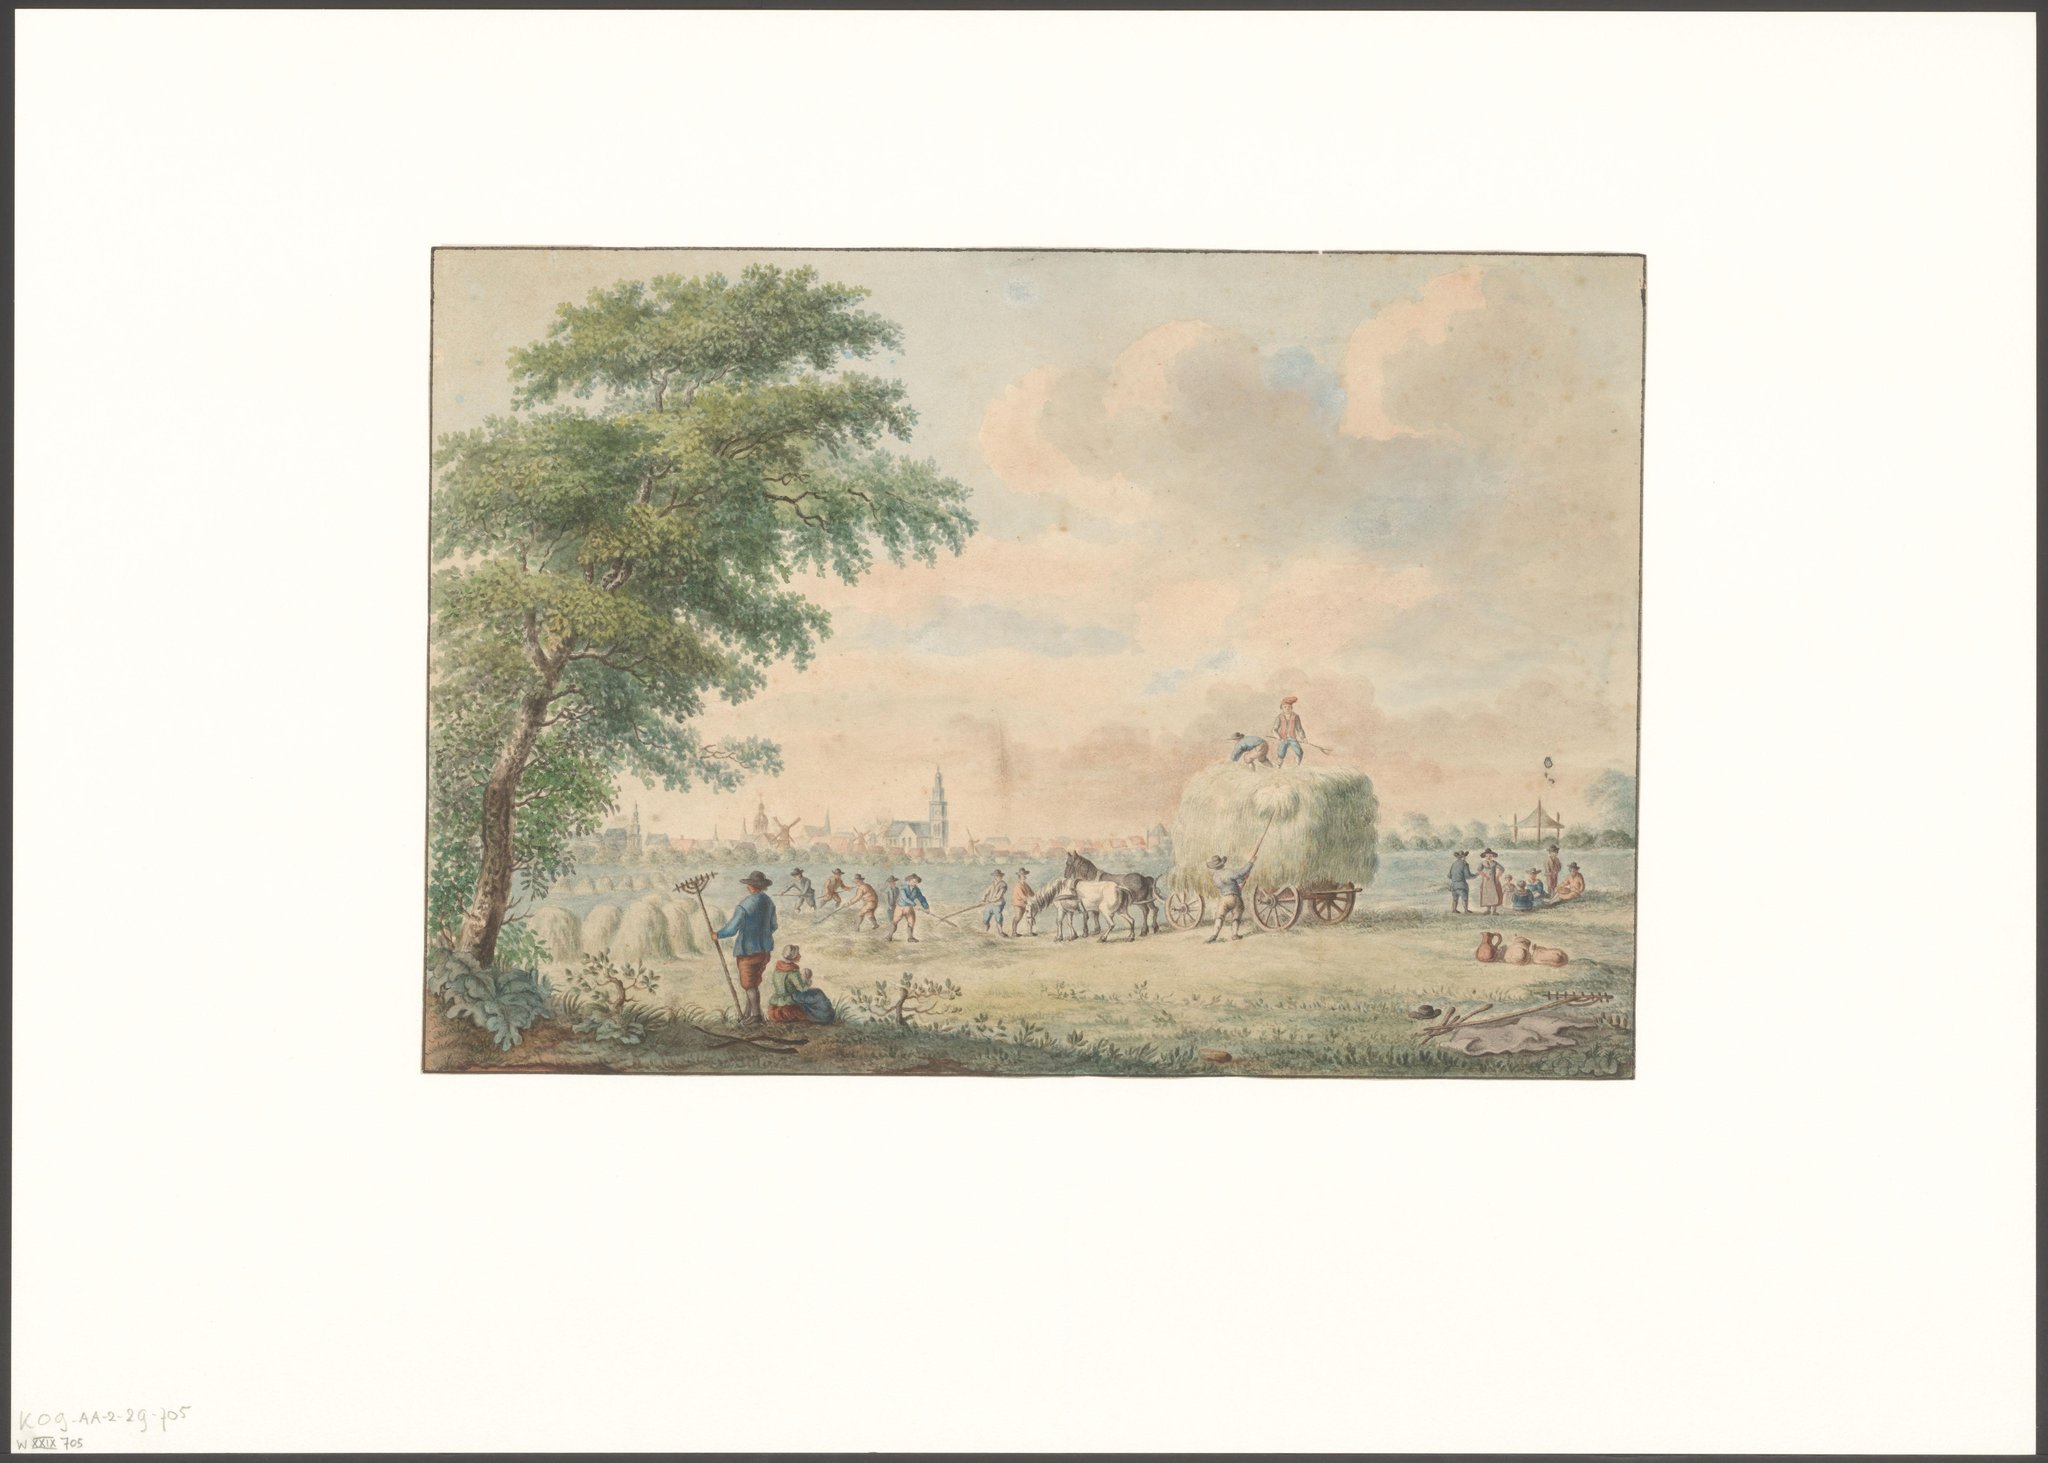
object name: drawing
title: Gezicht op hooiende boeren buiten Amsterdam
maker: Anonymous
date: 1750-1850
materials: paper, pencil, watercolor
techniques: brush, pen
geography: amsterdam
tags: city-view in general; 'veduta', farmers, gleaning, amsterdam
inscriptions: collector's mark: Lugt 800a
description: Tekening binnen de Atlas Van Eck ingedeeld op wijknummer 29.